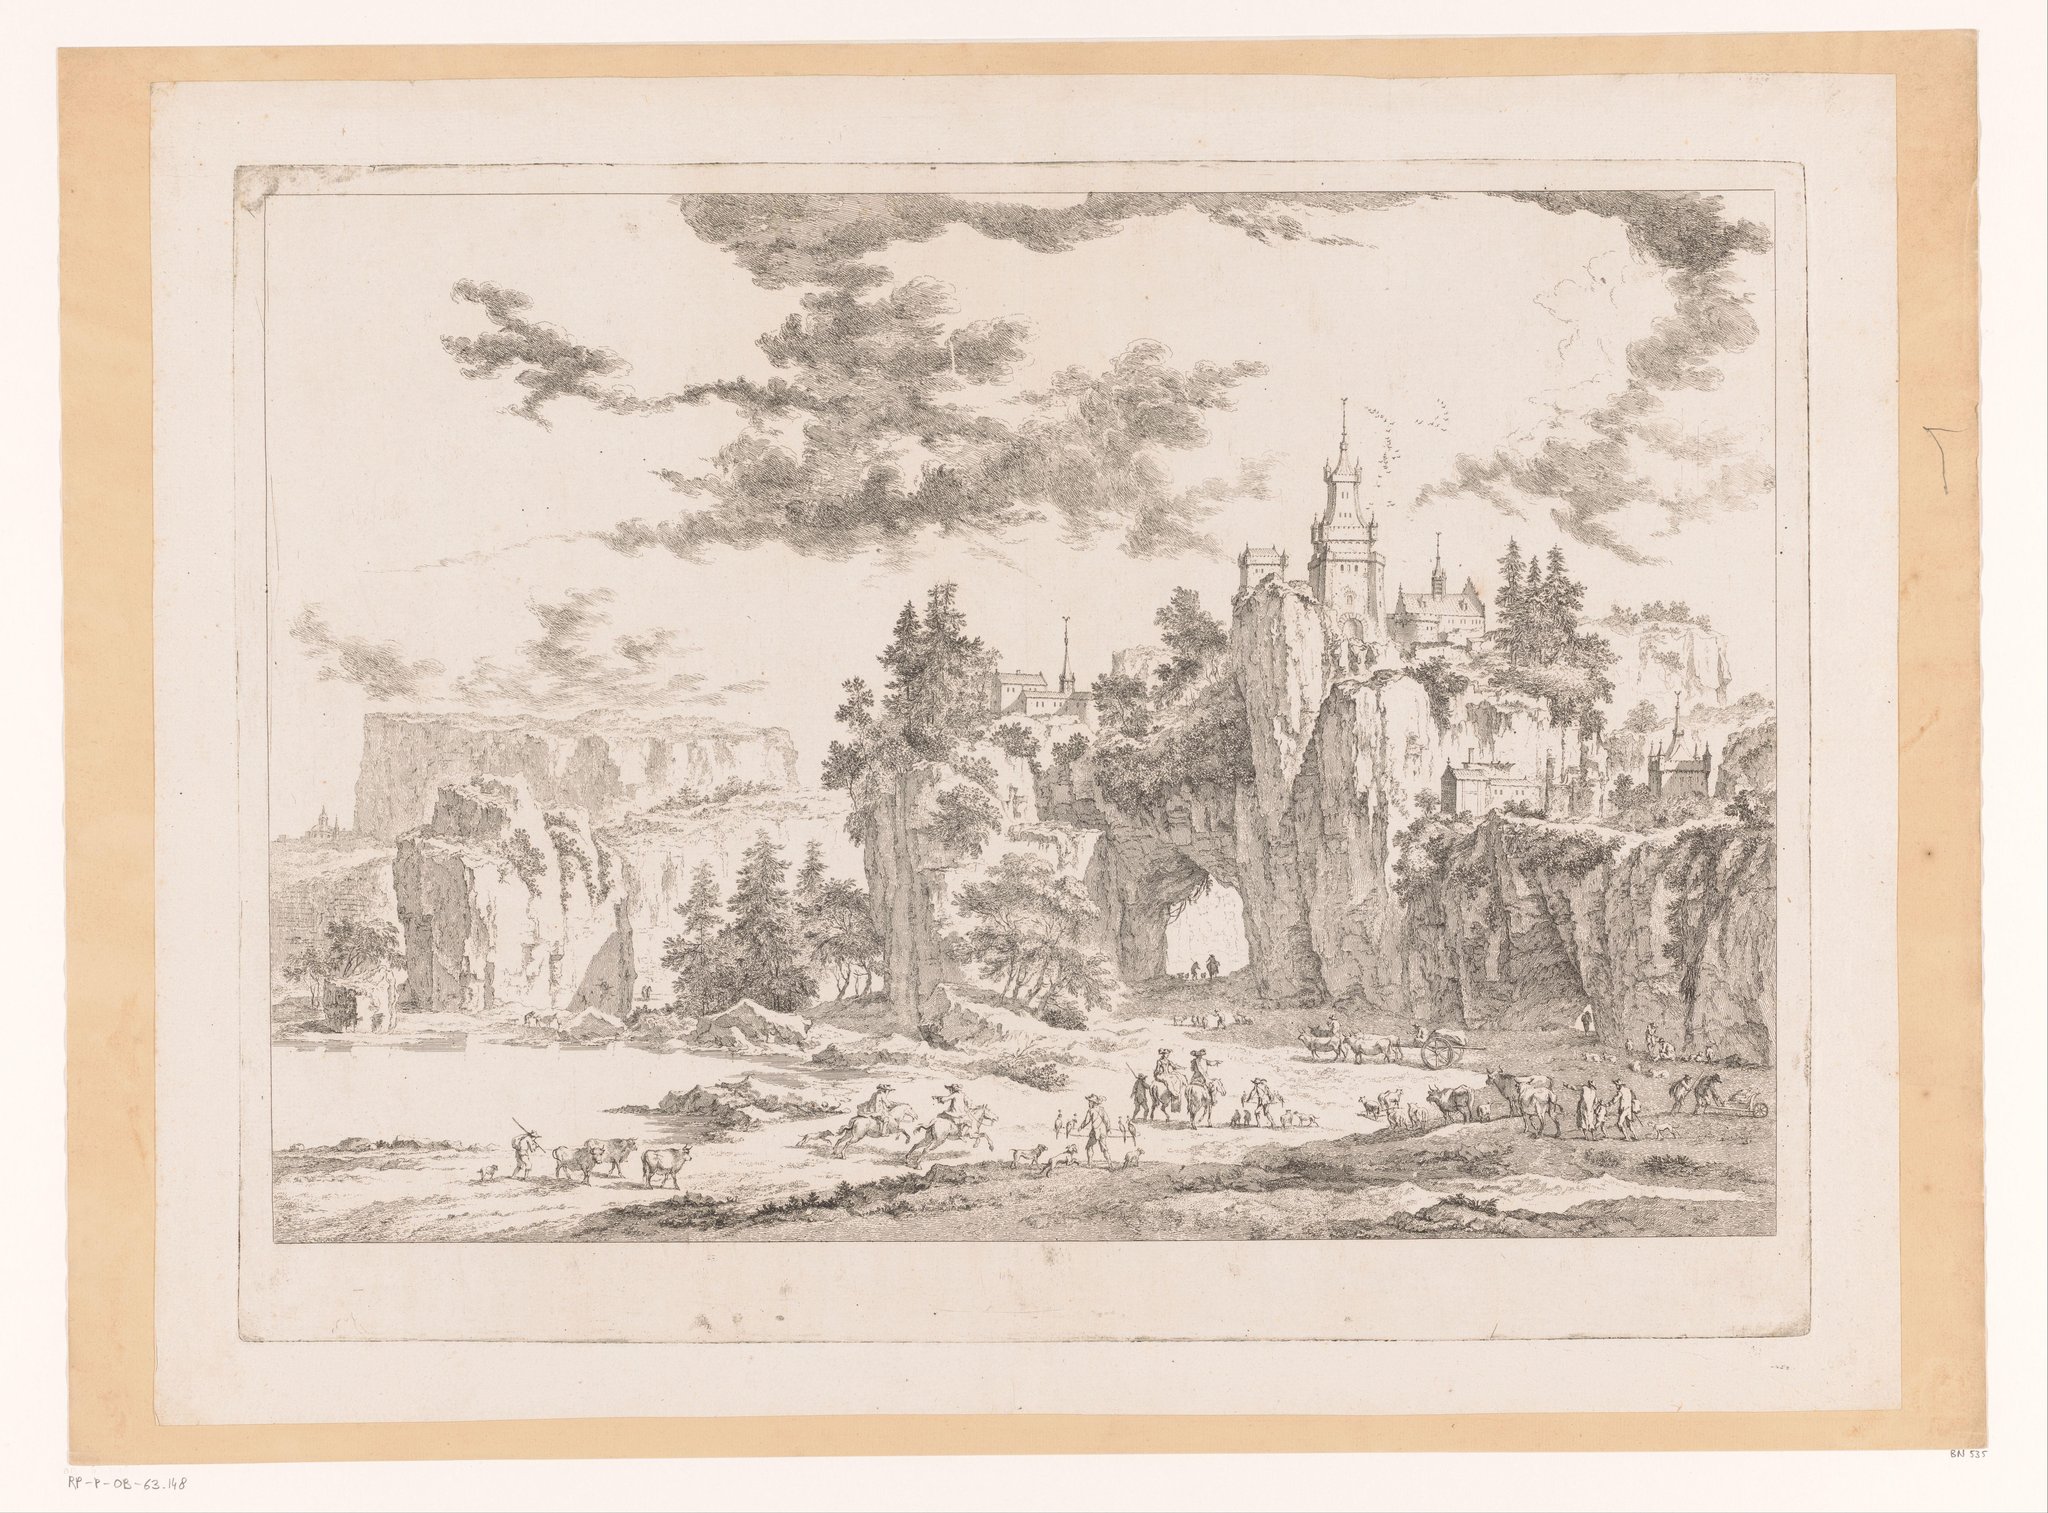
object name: print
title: Le Depart pour la Chasse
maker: gabriel huquier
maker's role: painter, print maker, publisher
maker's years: 1695-1772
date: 1772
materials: paper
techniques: etching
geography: paris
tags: castle, hunting, chase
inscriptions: collector's mark: Lugt 240